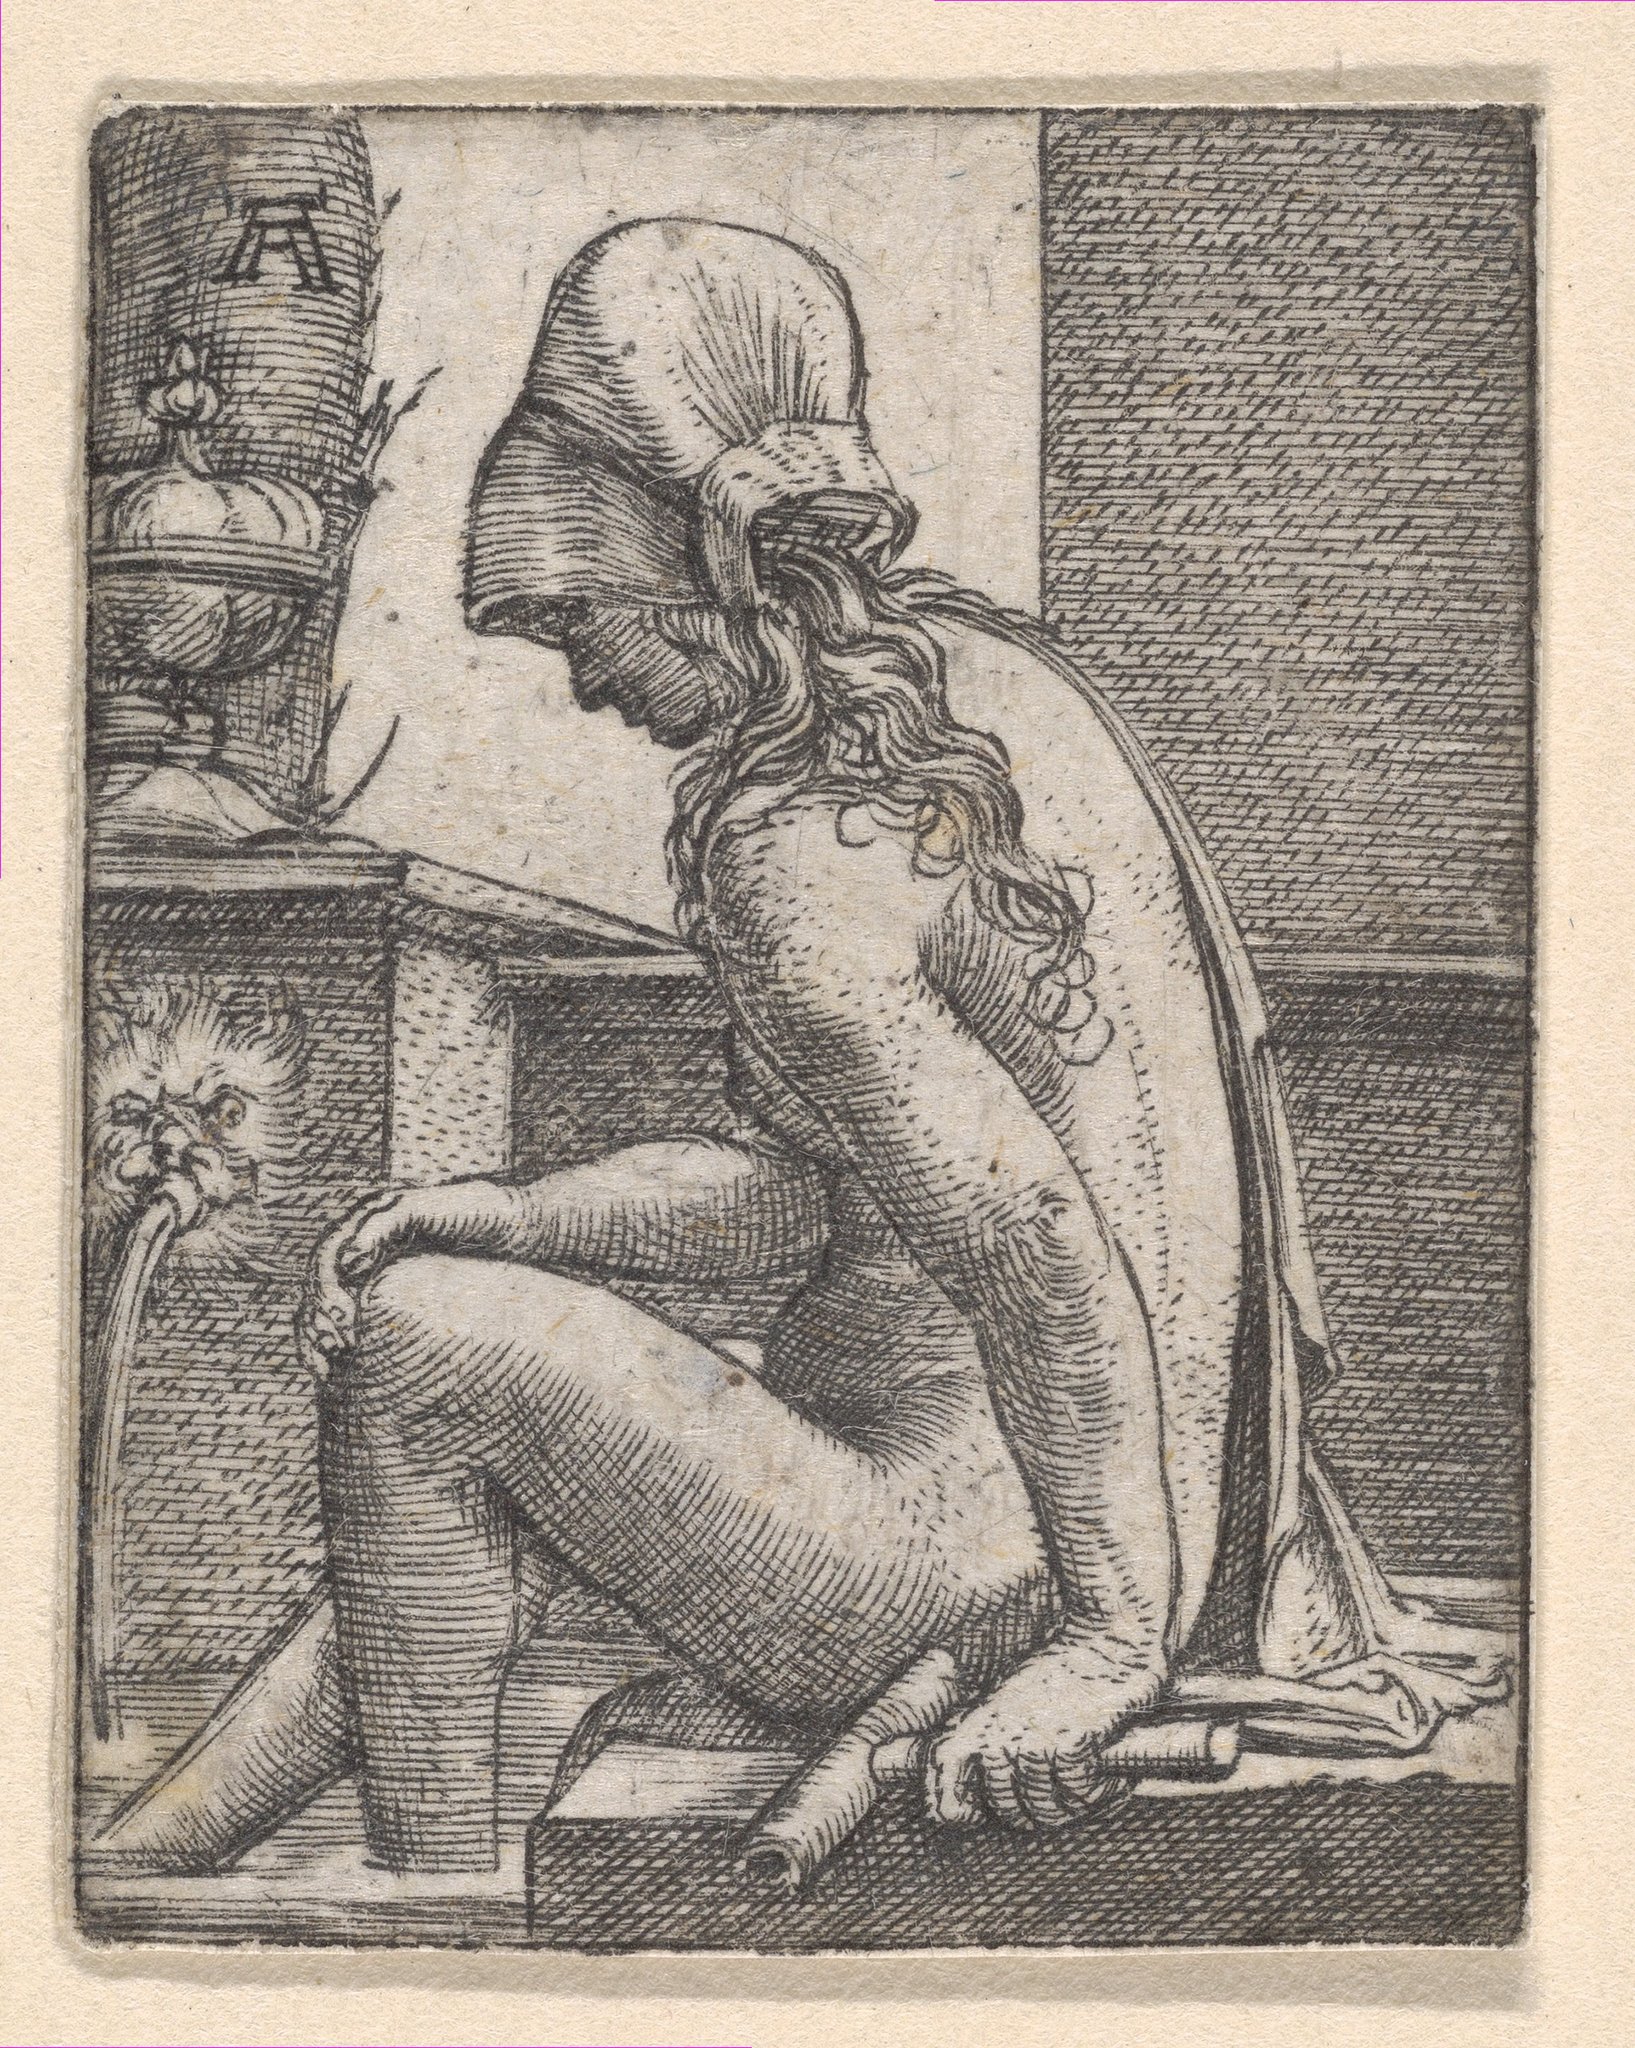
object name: print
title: Seated Woman Bathing Her Feet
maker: albrecht altdorfer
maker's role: artist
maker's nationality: german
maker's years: 1480-1538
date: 1500-1538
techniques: engraving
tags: female nudes,bathing